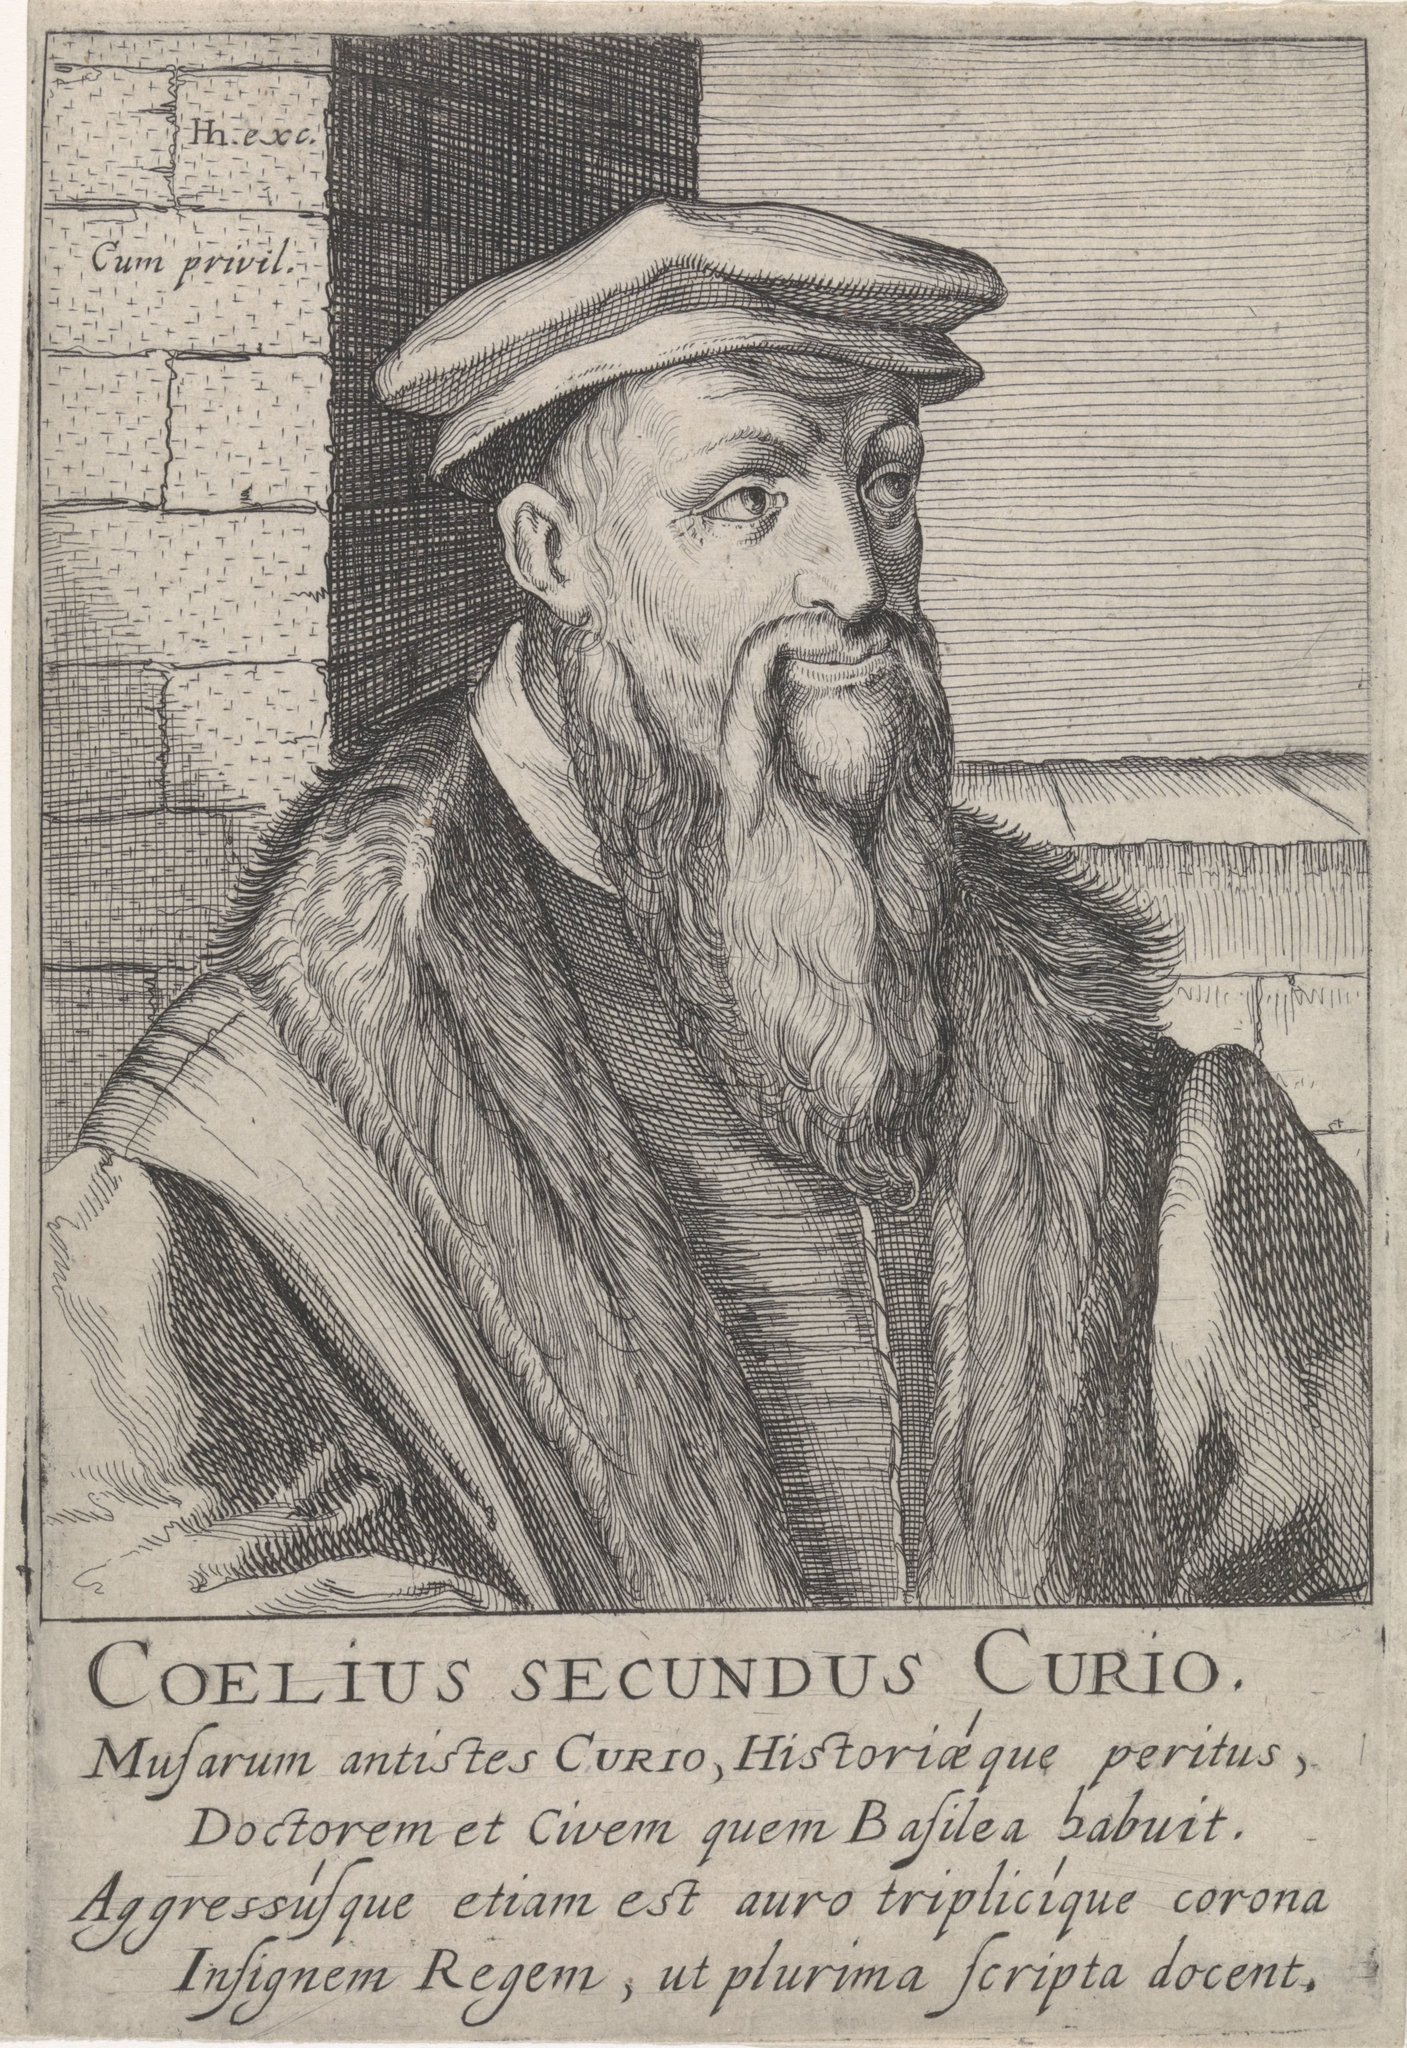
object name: print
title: Beroemde hervormers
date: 1610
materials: paper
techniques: etching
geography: the hague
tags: cirié, humanist, celio secundo curione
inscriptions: collector's mark: Lugt 2228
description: Buste naar rechts van Caelius Secundus Curio. Onder het portret zijn naam en vier regels in het Latijn. Prent uit het later toegevoegde deel 2 (28 prenten) van de serie portretten van beroemde hervormers door Hendrick Hondius uit 1599.